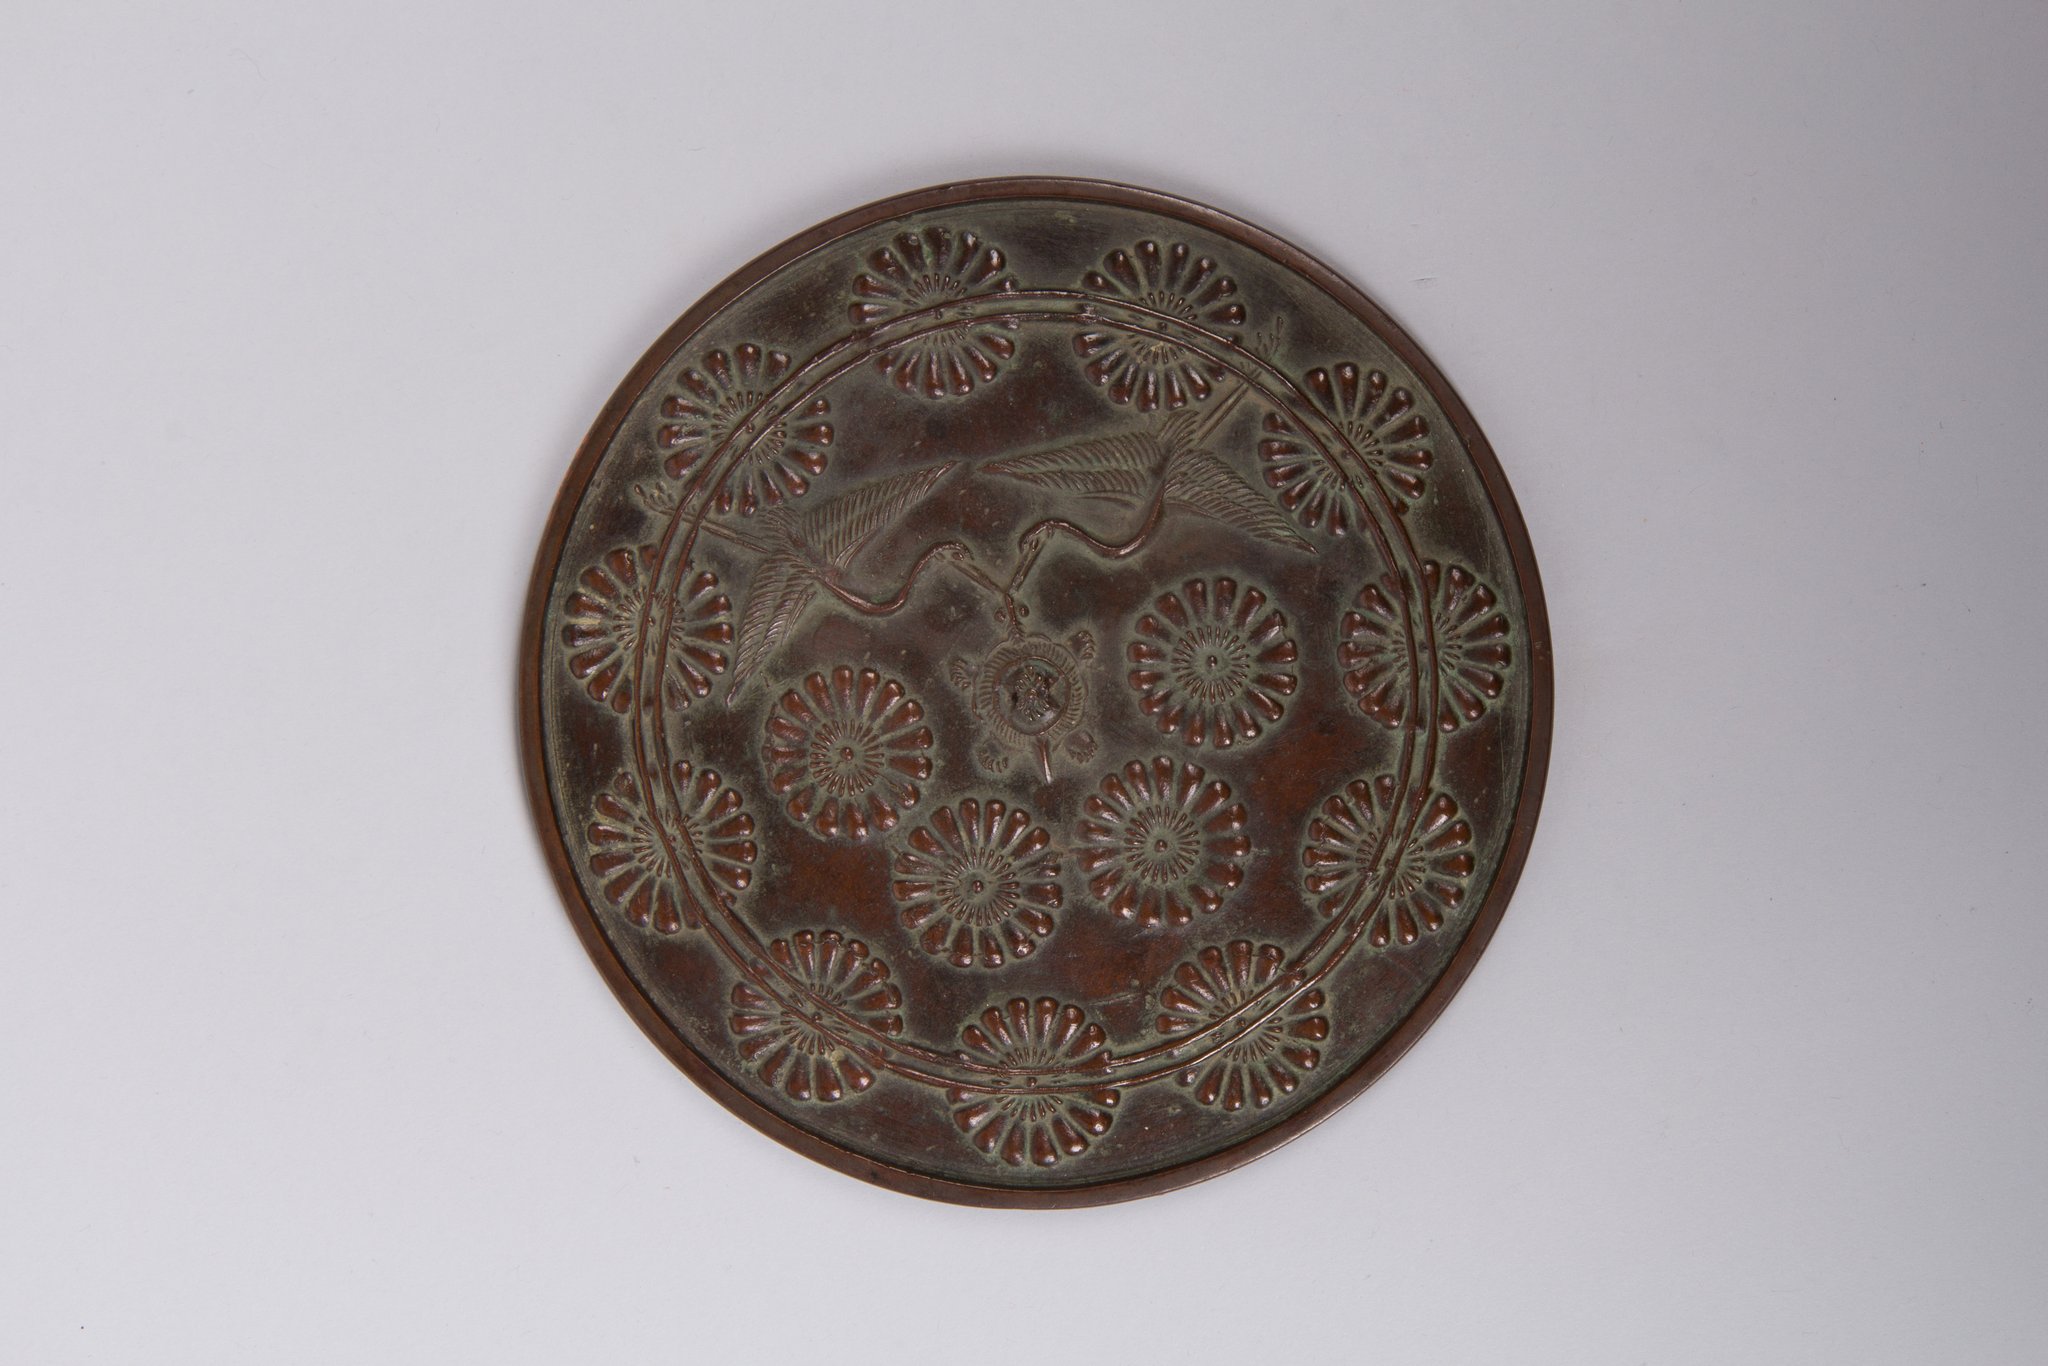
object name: mirror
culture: japanese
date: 1336-1573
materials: bronze